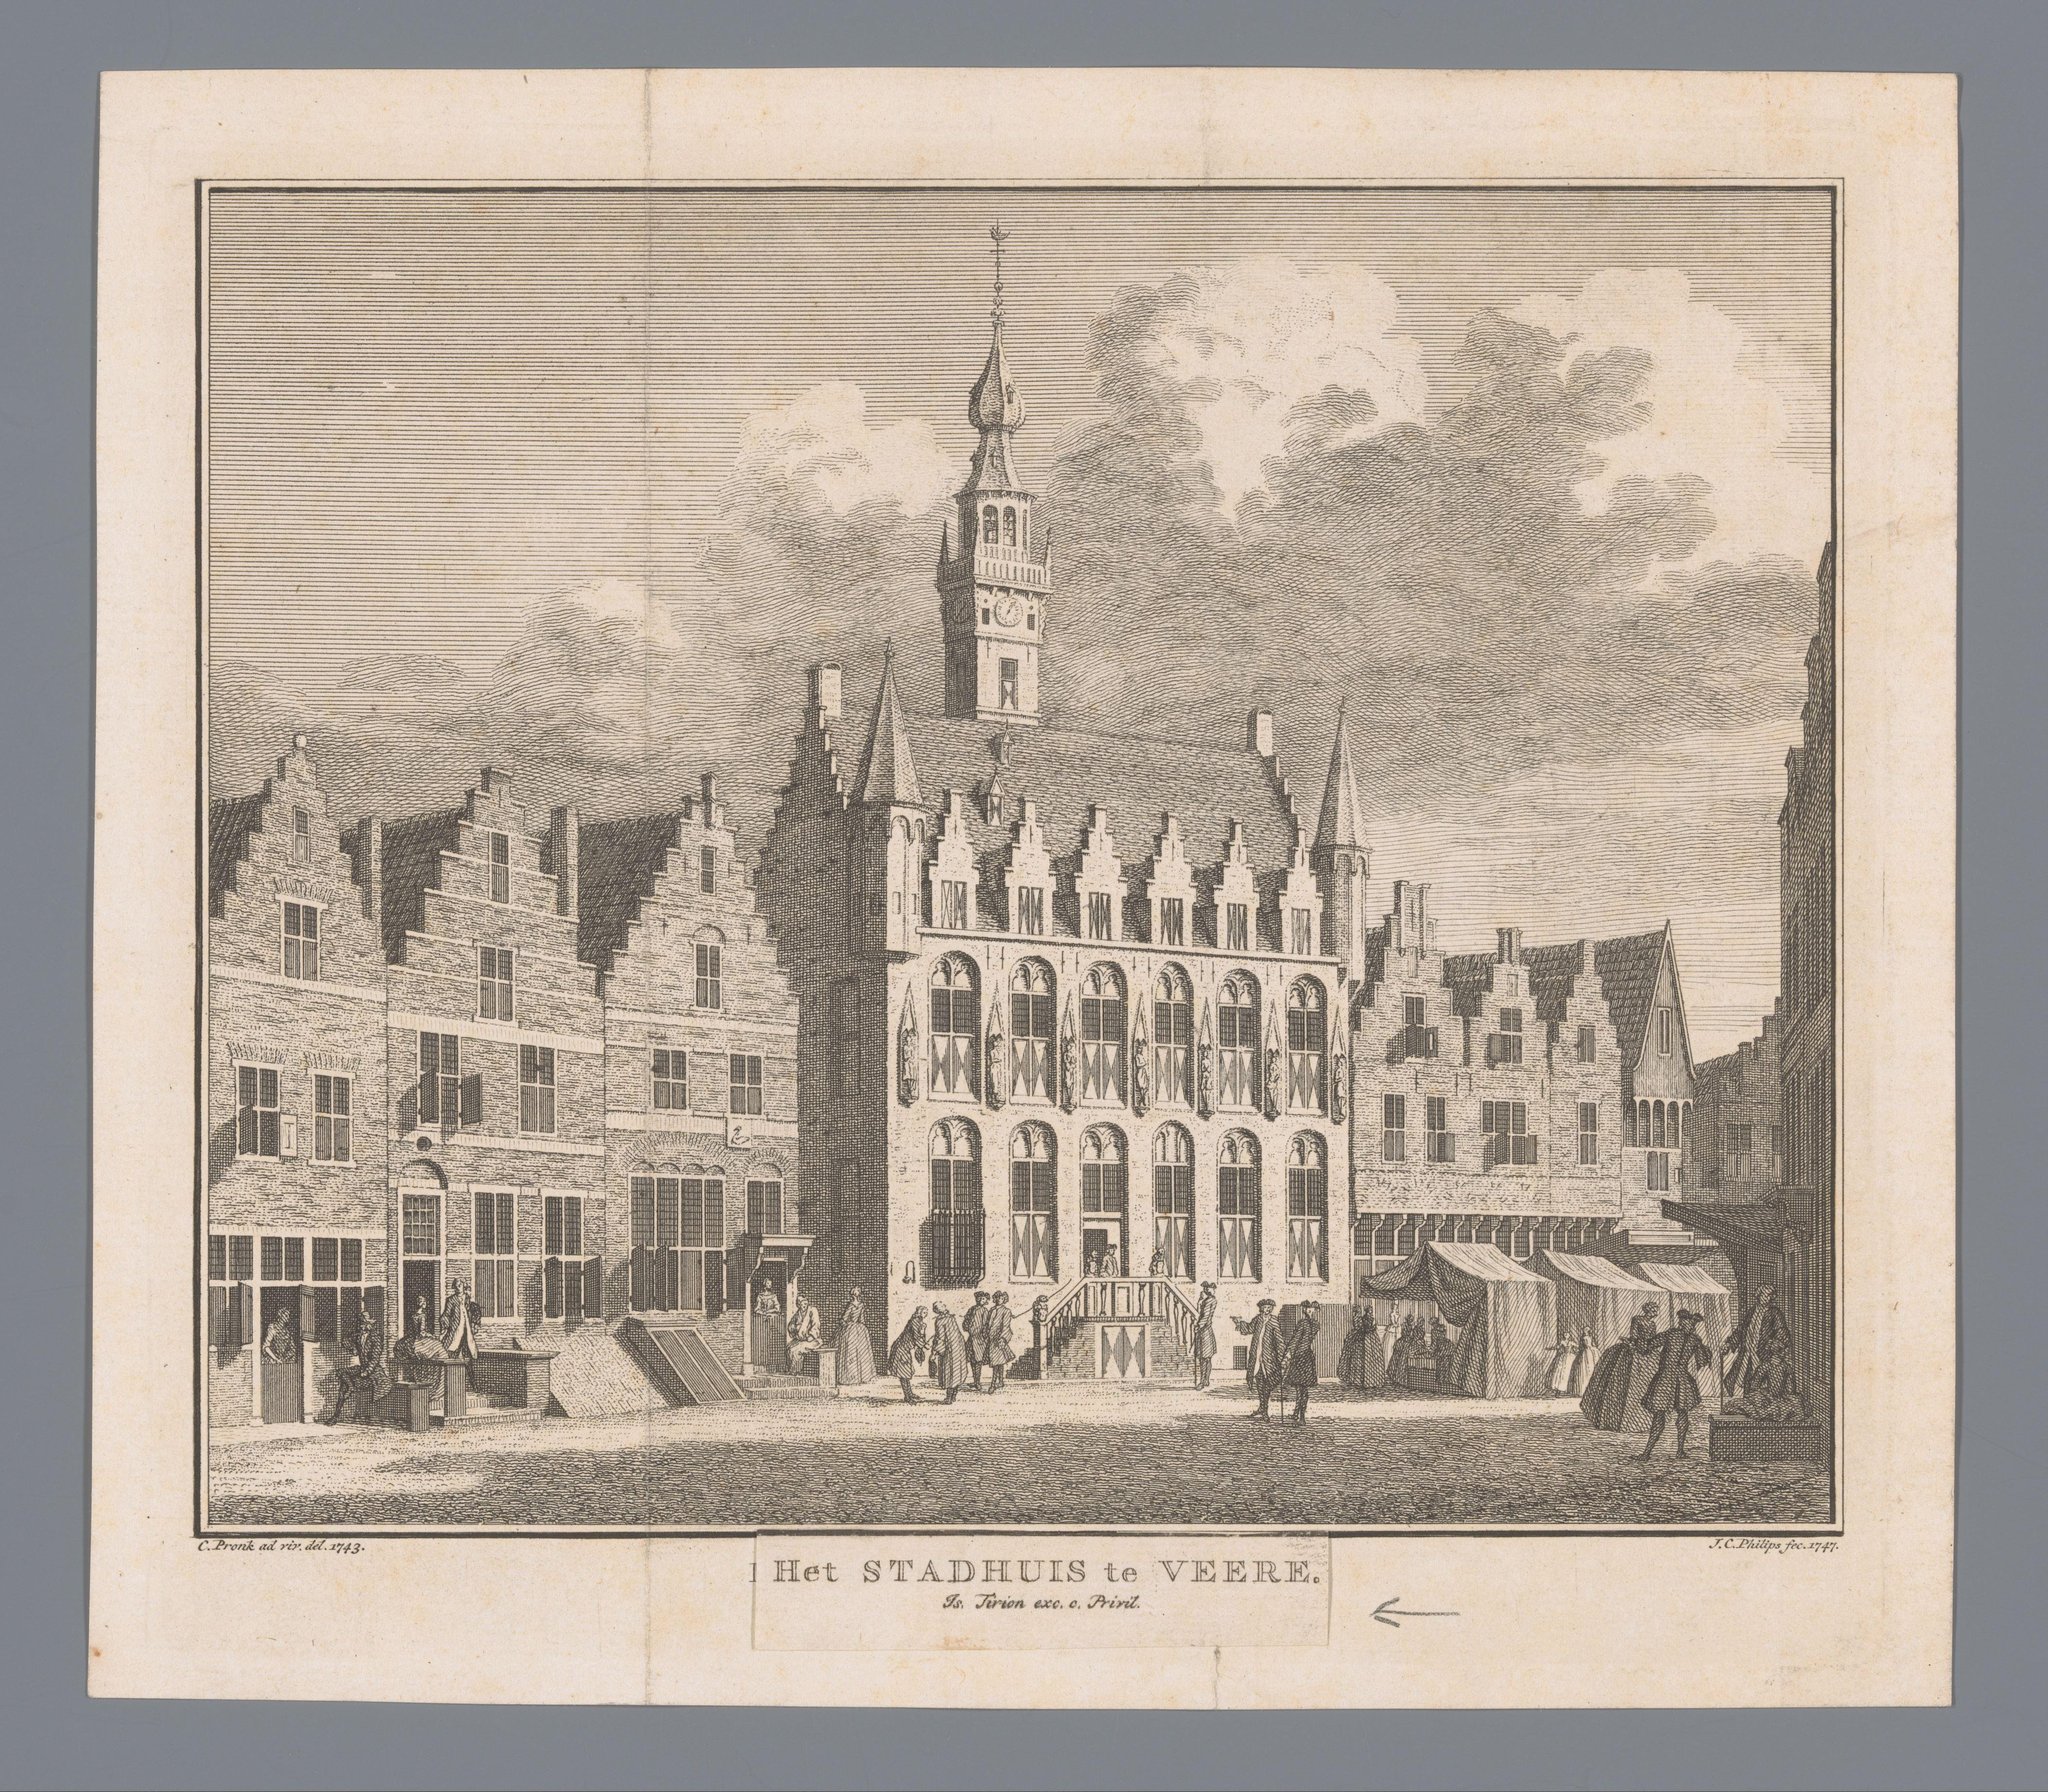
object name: print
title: Gezicht op het stadhuis van Veere, 1743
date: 1747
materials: paper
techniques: etching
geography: amsterdam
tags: townhall, square, place, circus, etc. (+ city(-scape) with figures, staffage)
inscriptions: date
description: Tijdens het maken van de platen is op de plaat van deze prent de verkeerde titel gezet: 'Het stadhuis te Vlissingen'. De juiste titel met het adres van Isaak Tirion is hieroverheen geplakt. Prent ook gebruikt in: Wagenaar, Jan. Tegenwoordige staat der Vereenigde Nederlanden (...). Amsterdam: Isaak Tirion, 1753, dl. 10, tussen p. 168 en 169.